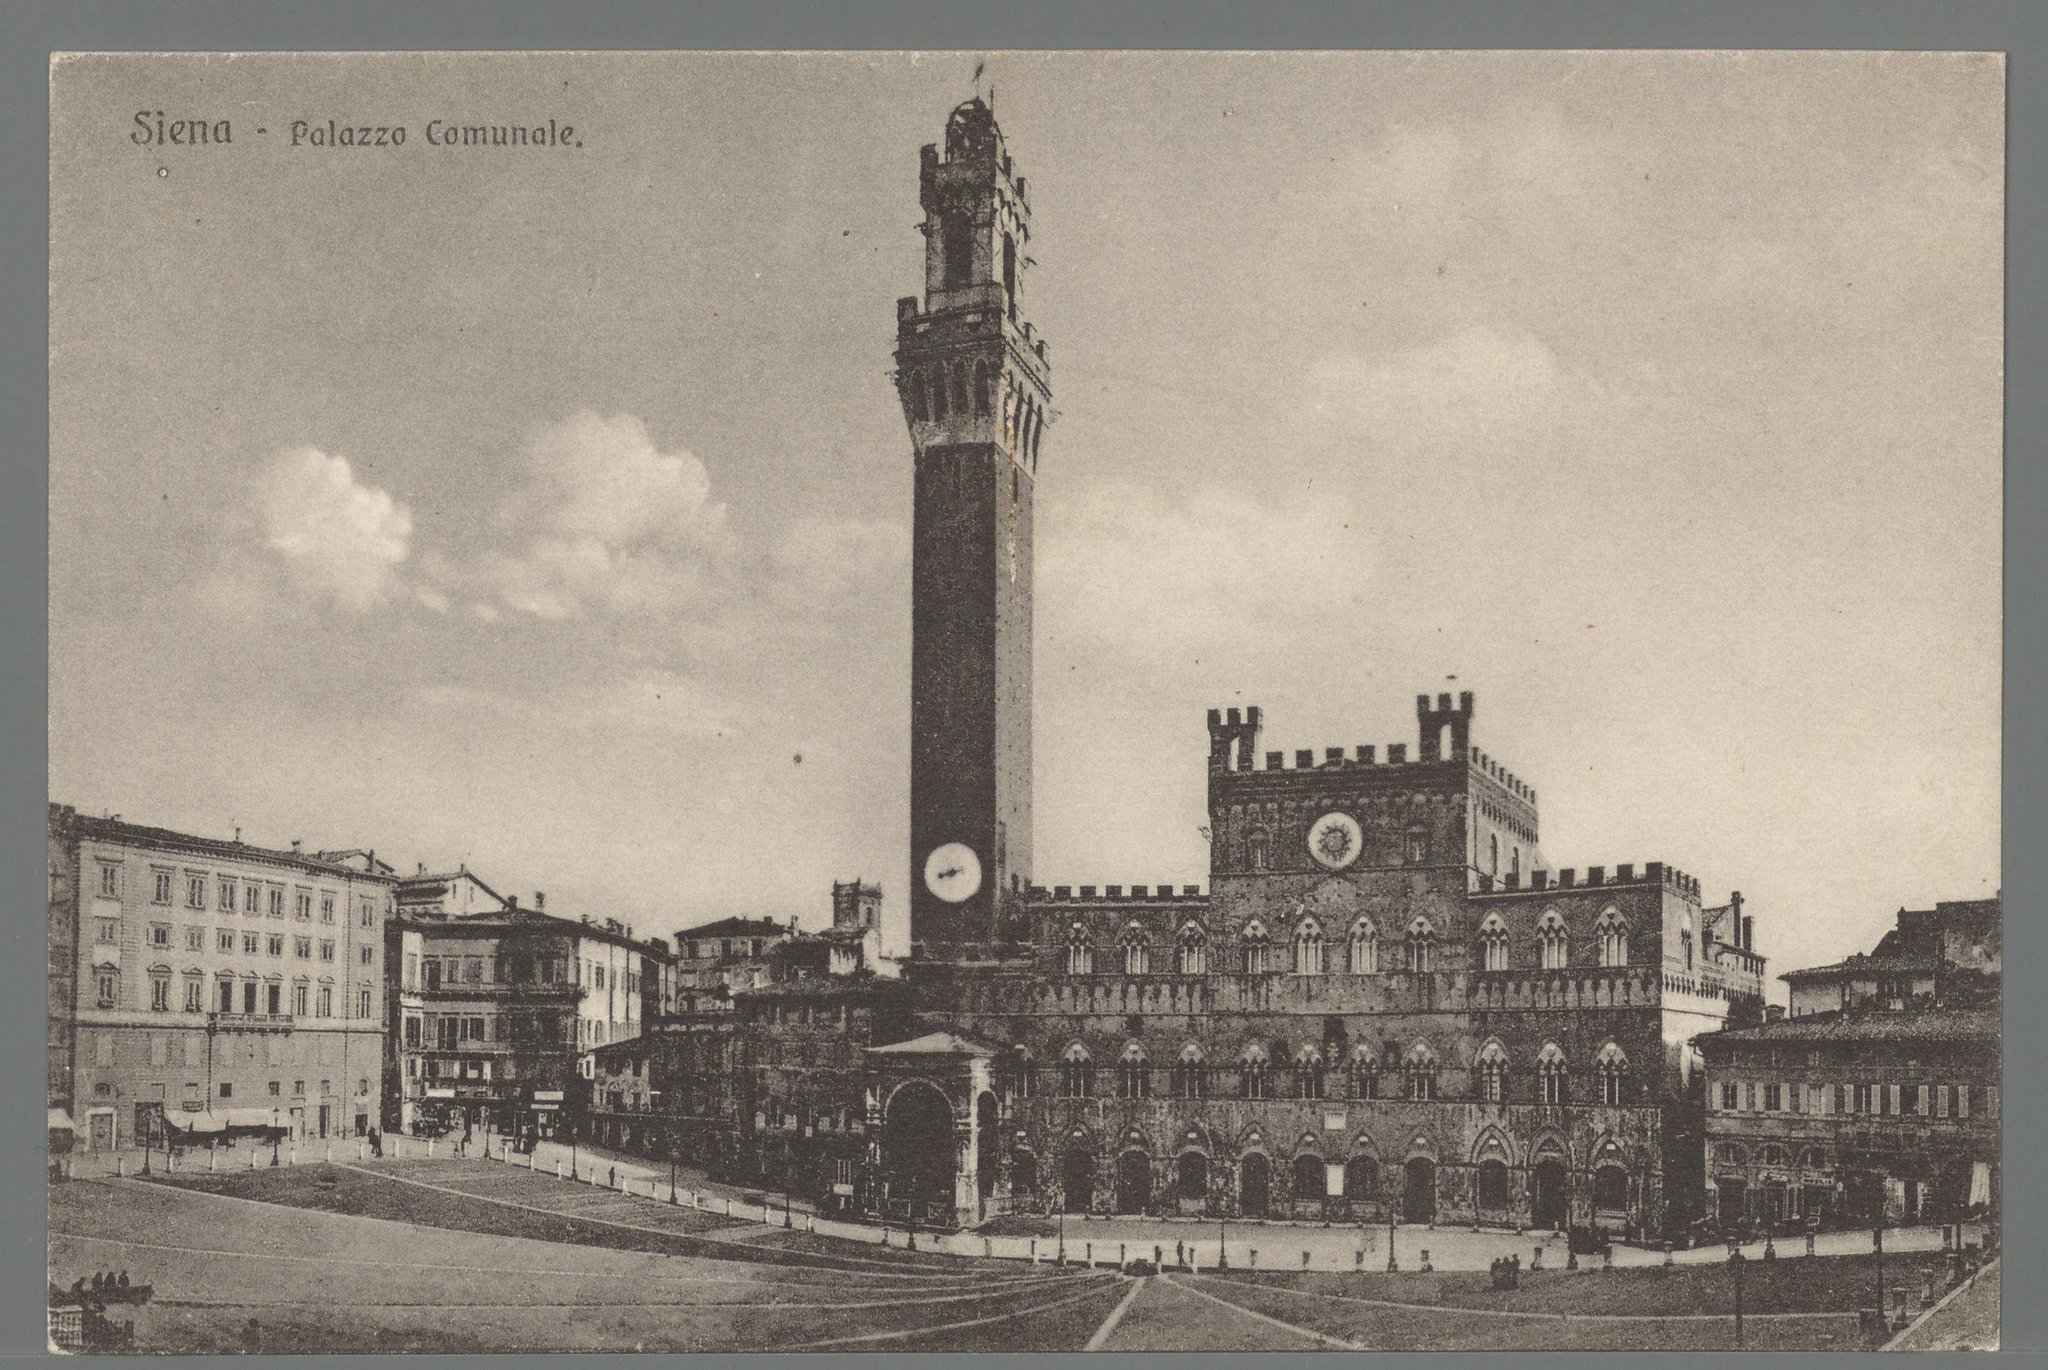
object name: photomechanical print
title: Siena. Palazzo Comunale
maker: Anonymous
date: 1906-1930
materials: cardboard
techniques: photograph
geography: siena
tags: townhall, square, place, circus, etc. (+ city(-scape) with figures, staffage)